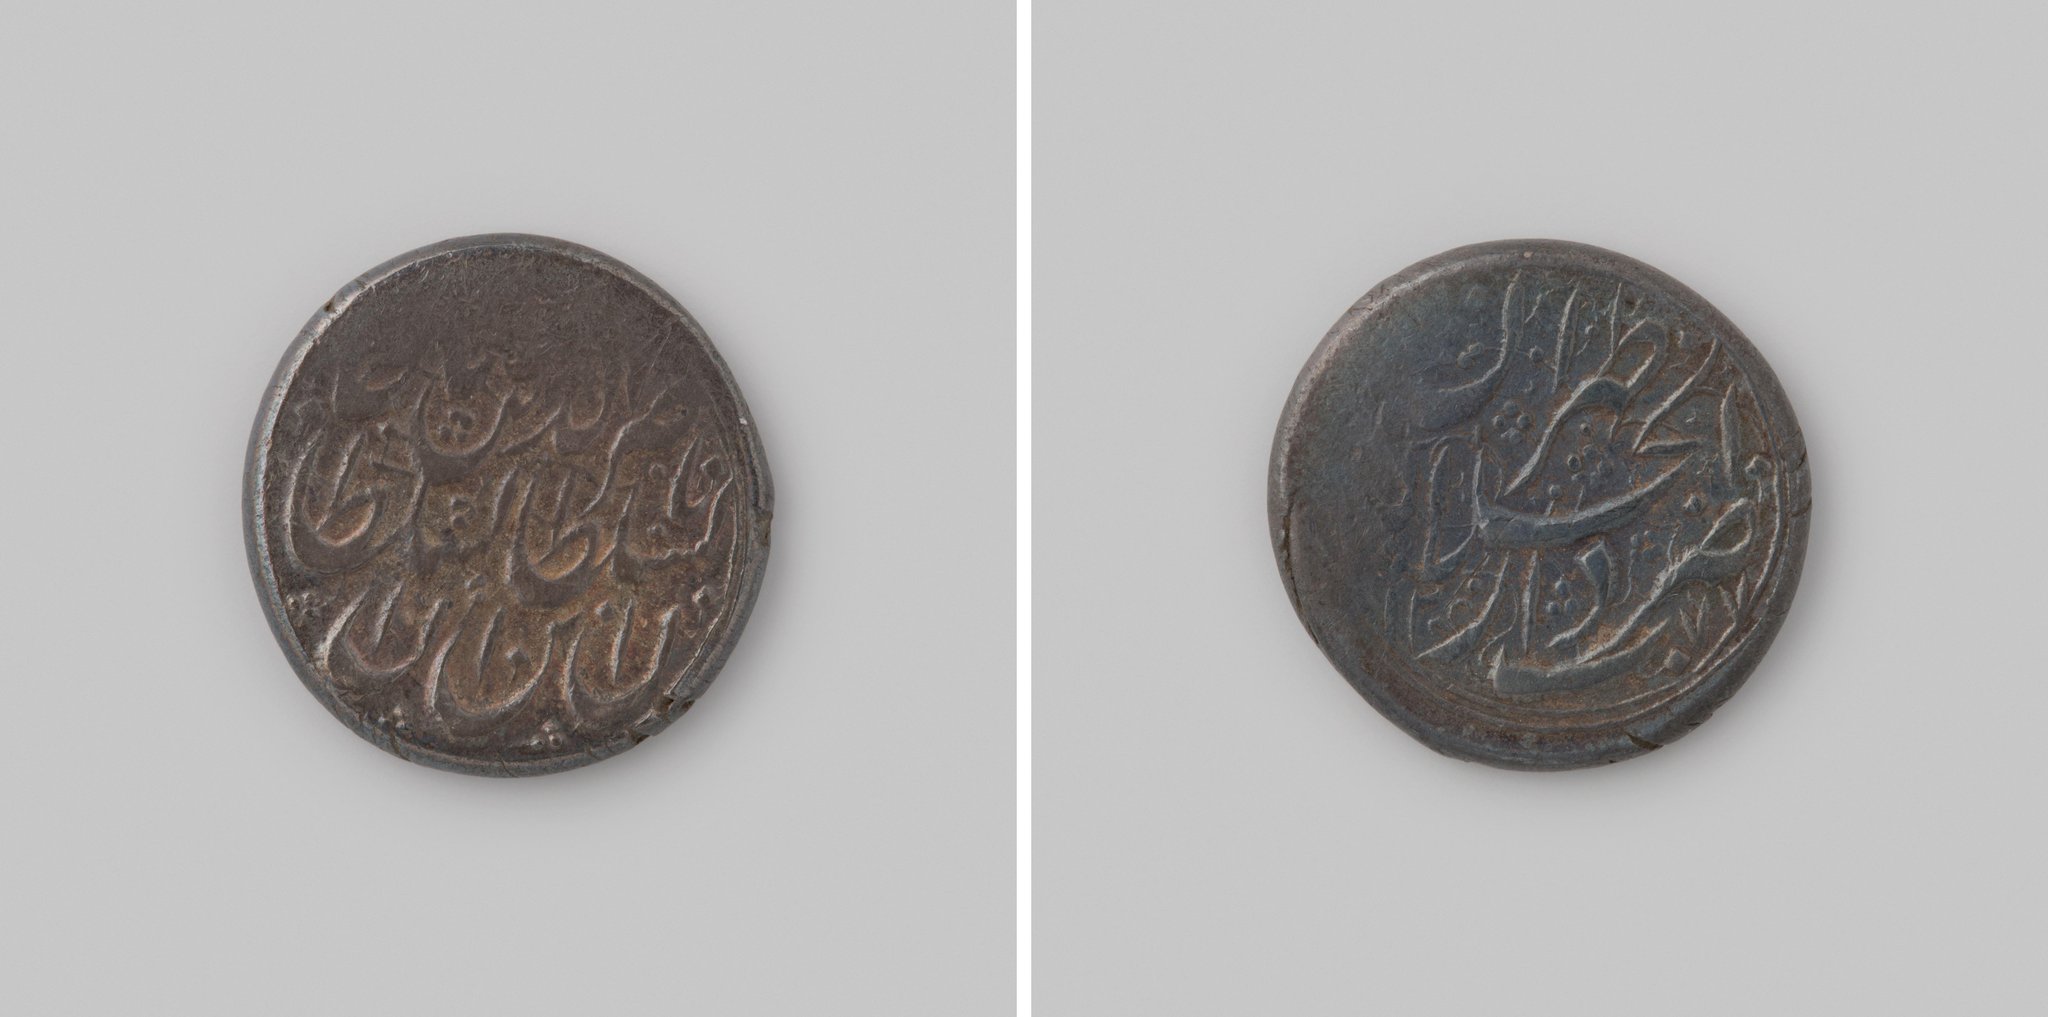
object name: coin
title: Dirhem uit het Oosten van Rusland van Khidr Khan van de Gouden Horde, 761-762 [=1359-1360] uit Kiptsjak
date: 1360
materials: silver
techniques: striking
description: Zilveren munt. Voorzijde: in Arabische lettertekens in drie regels naam van de vorst. Keerzijde: in Arabische lettertekens in drie regels ondermeer muntplaats-aanduiding en jaartal: 771. Hoewel deze munt jaartal 771 aangeeft, moet dit 761 zijn. De munten van deze dynastie wemelen van verkeerde jaartallen.